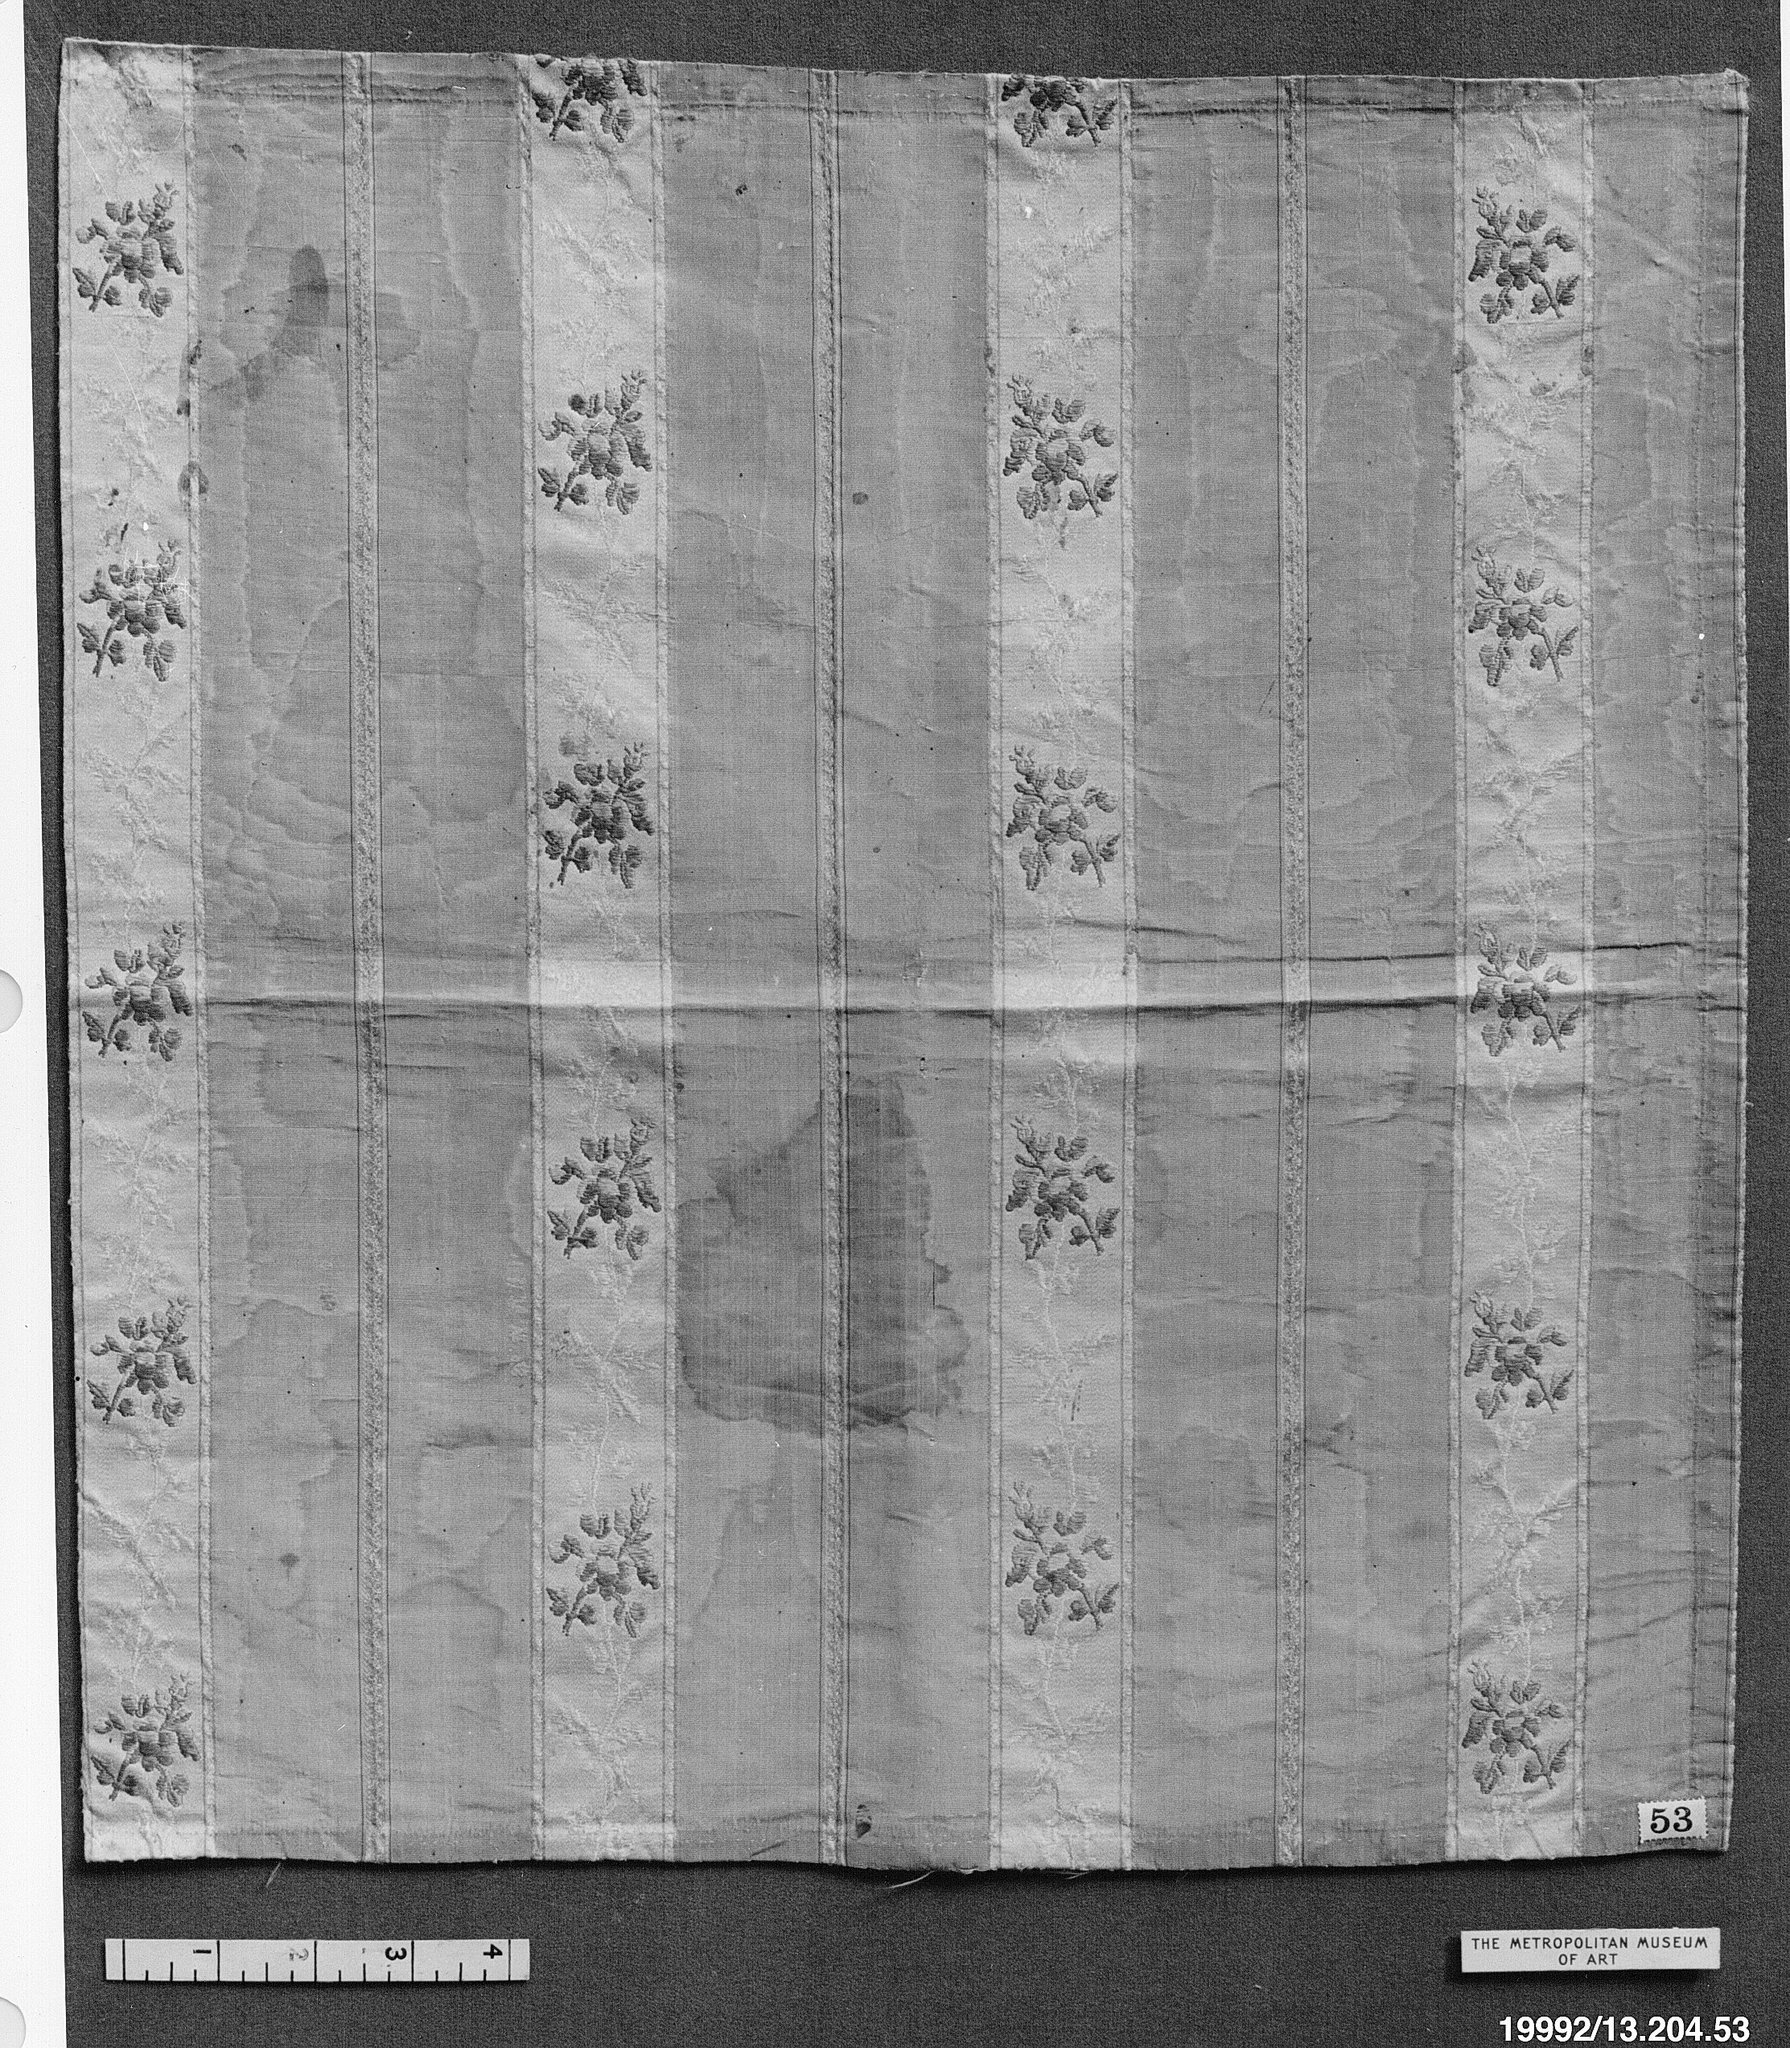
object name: piece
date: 1701-1800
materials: silk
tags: flowers,leaves